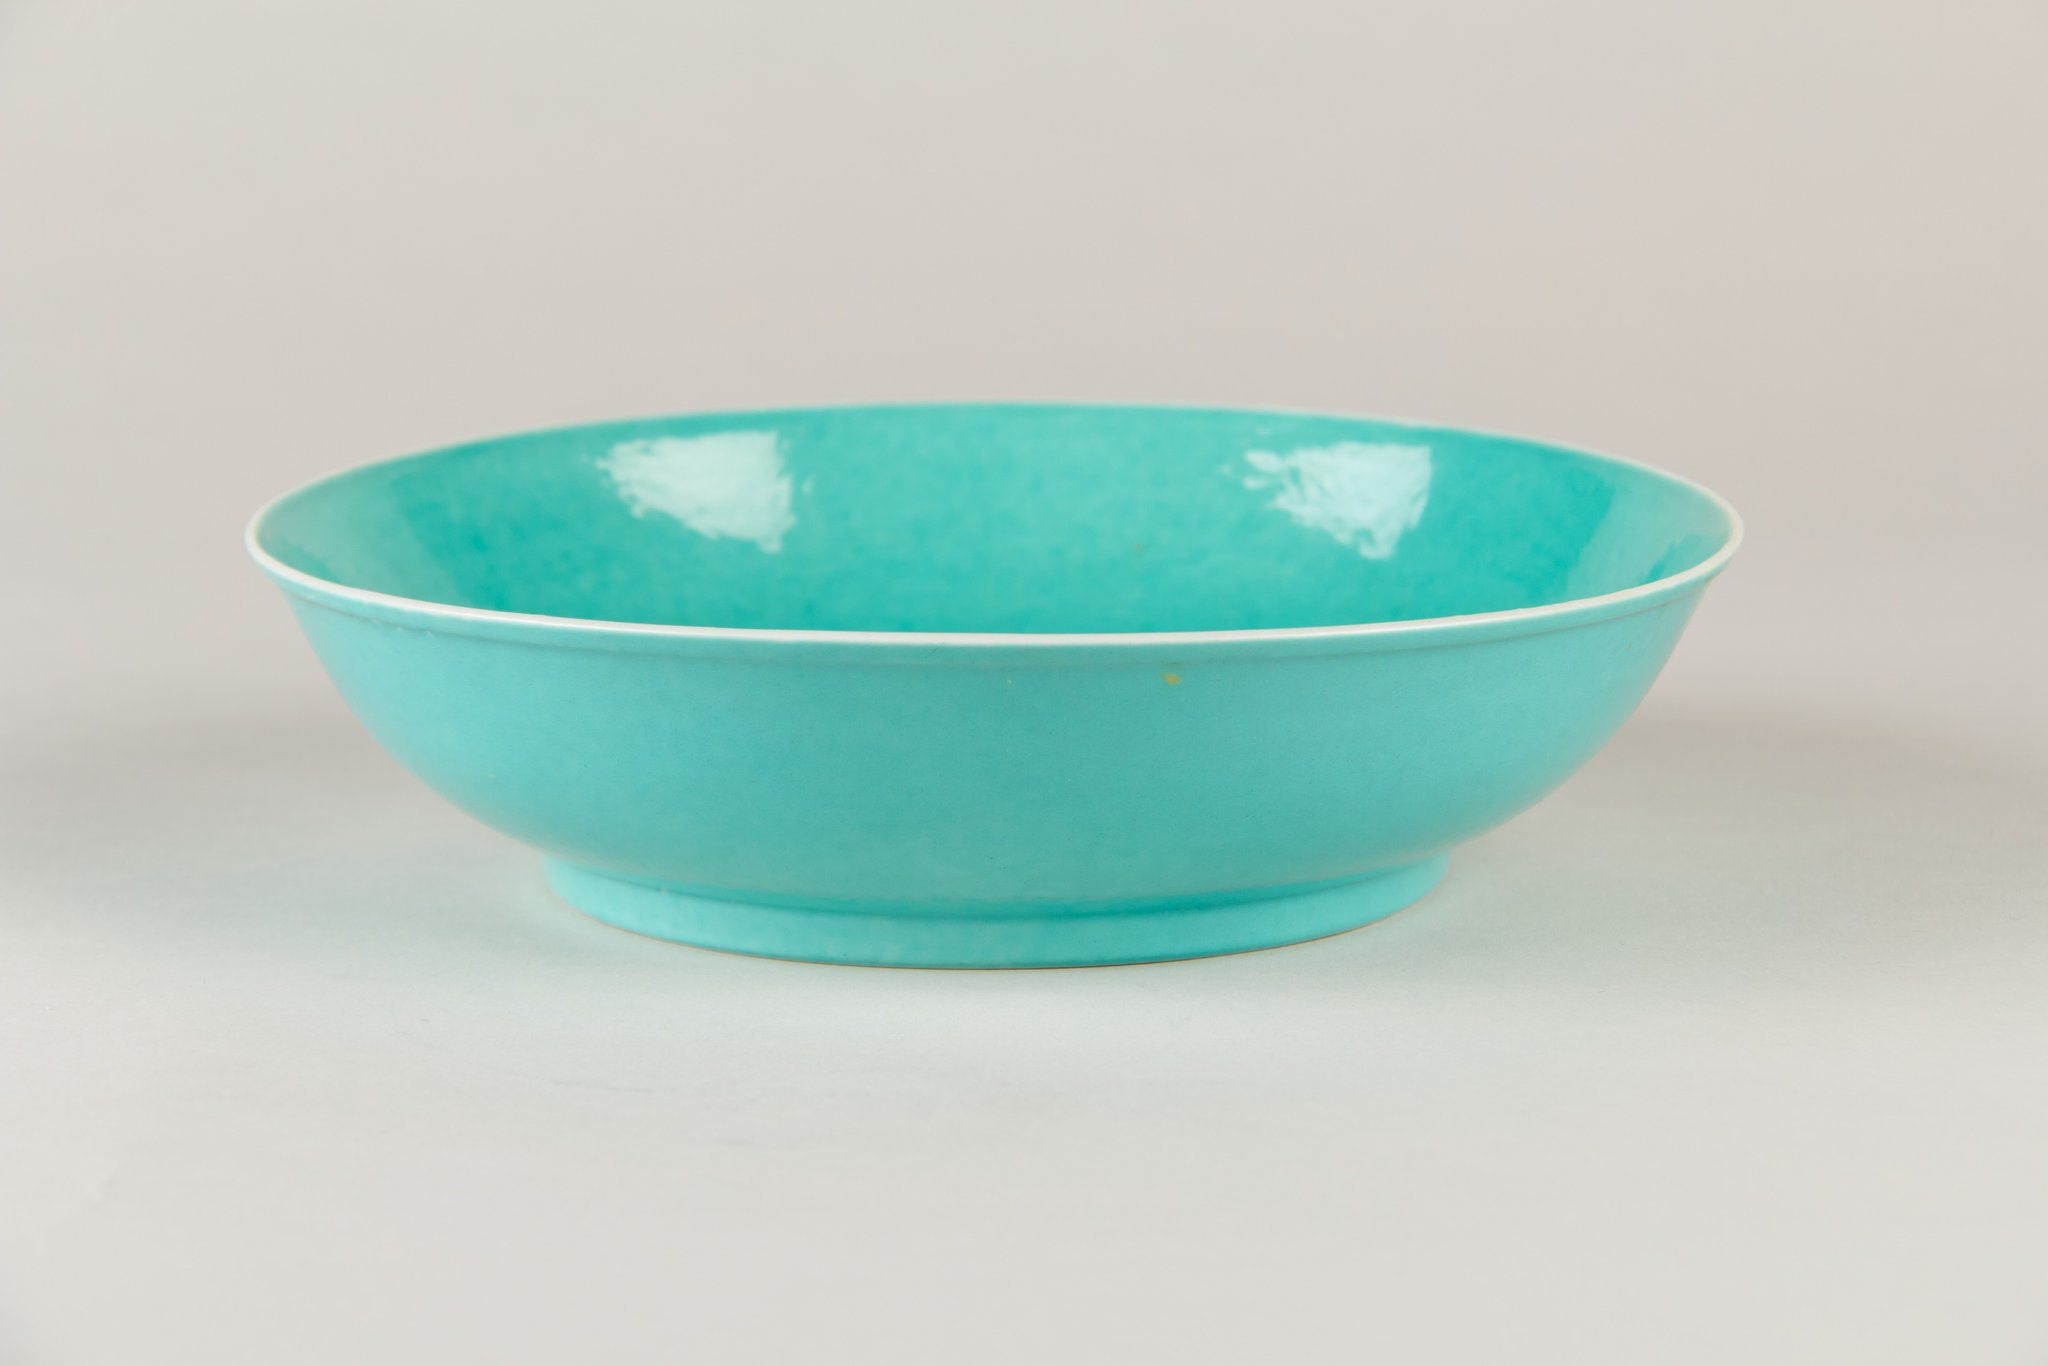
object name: dish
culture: chinese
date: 1867-1900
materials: glaze, porcelain